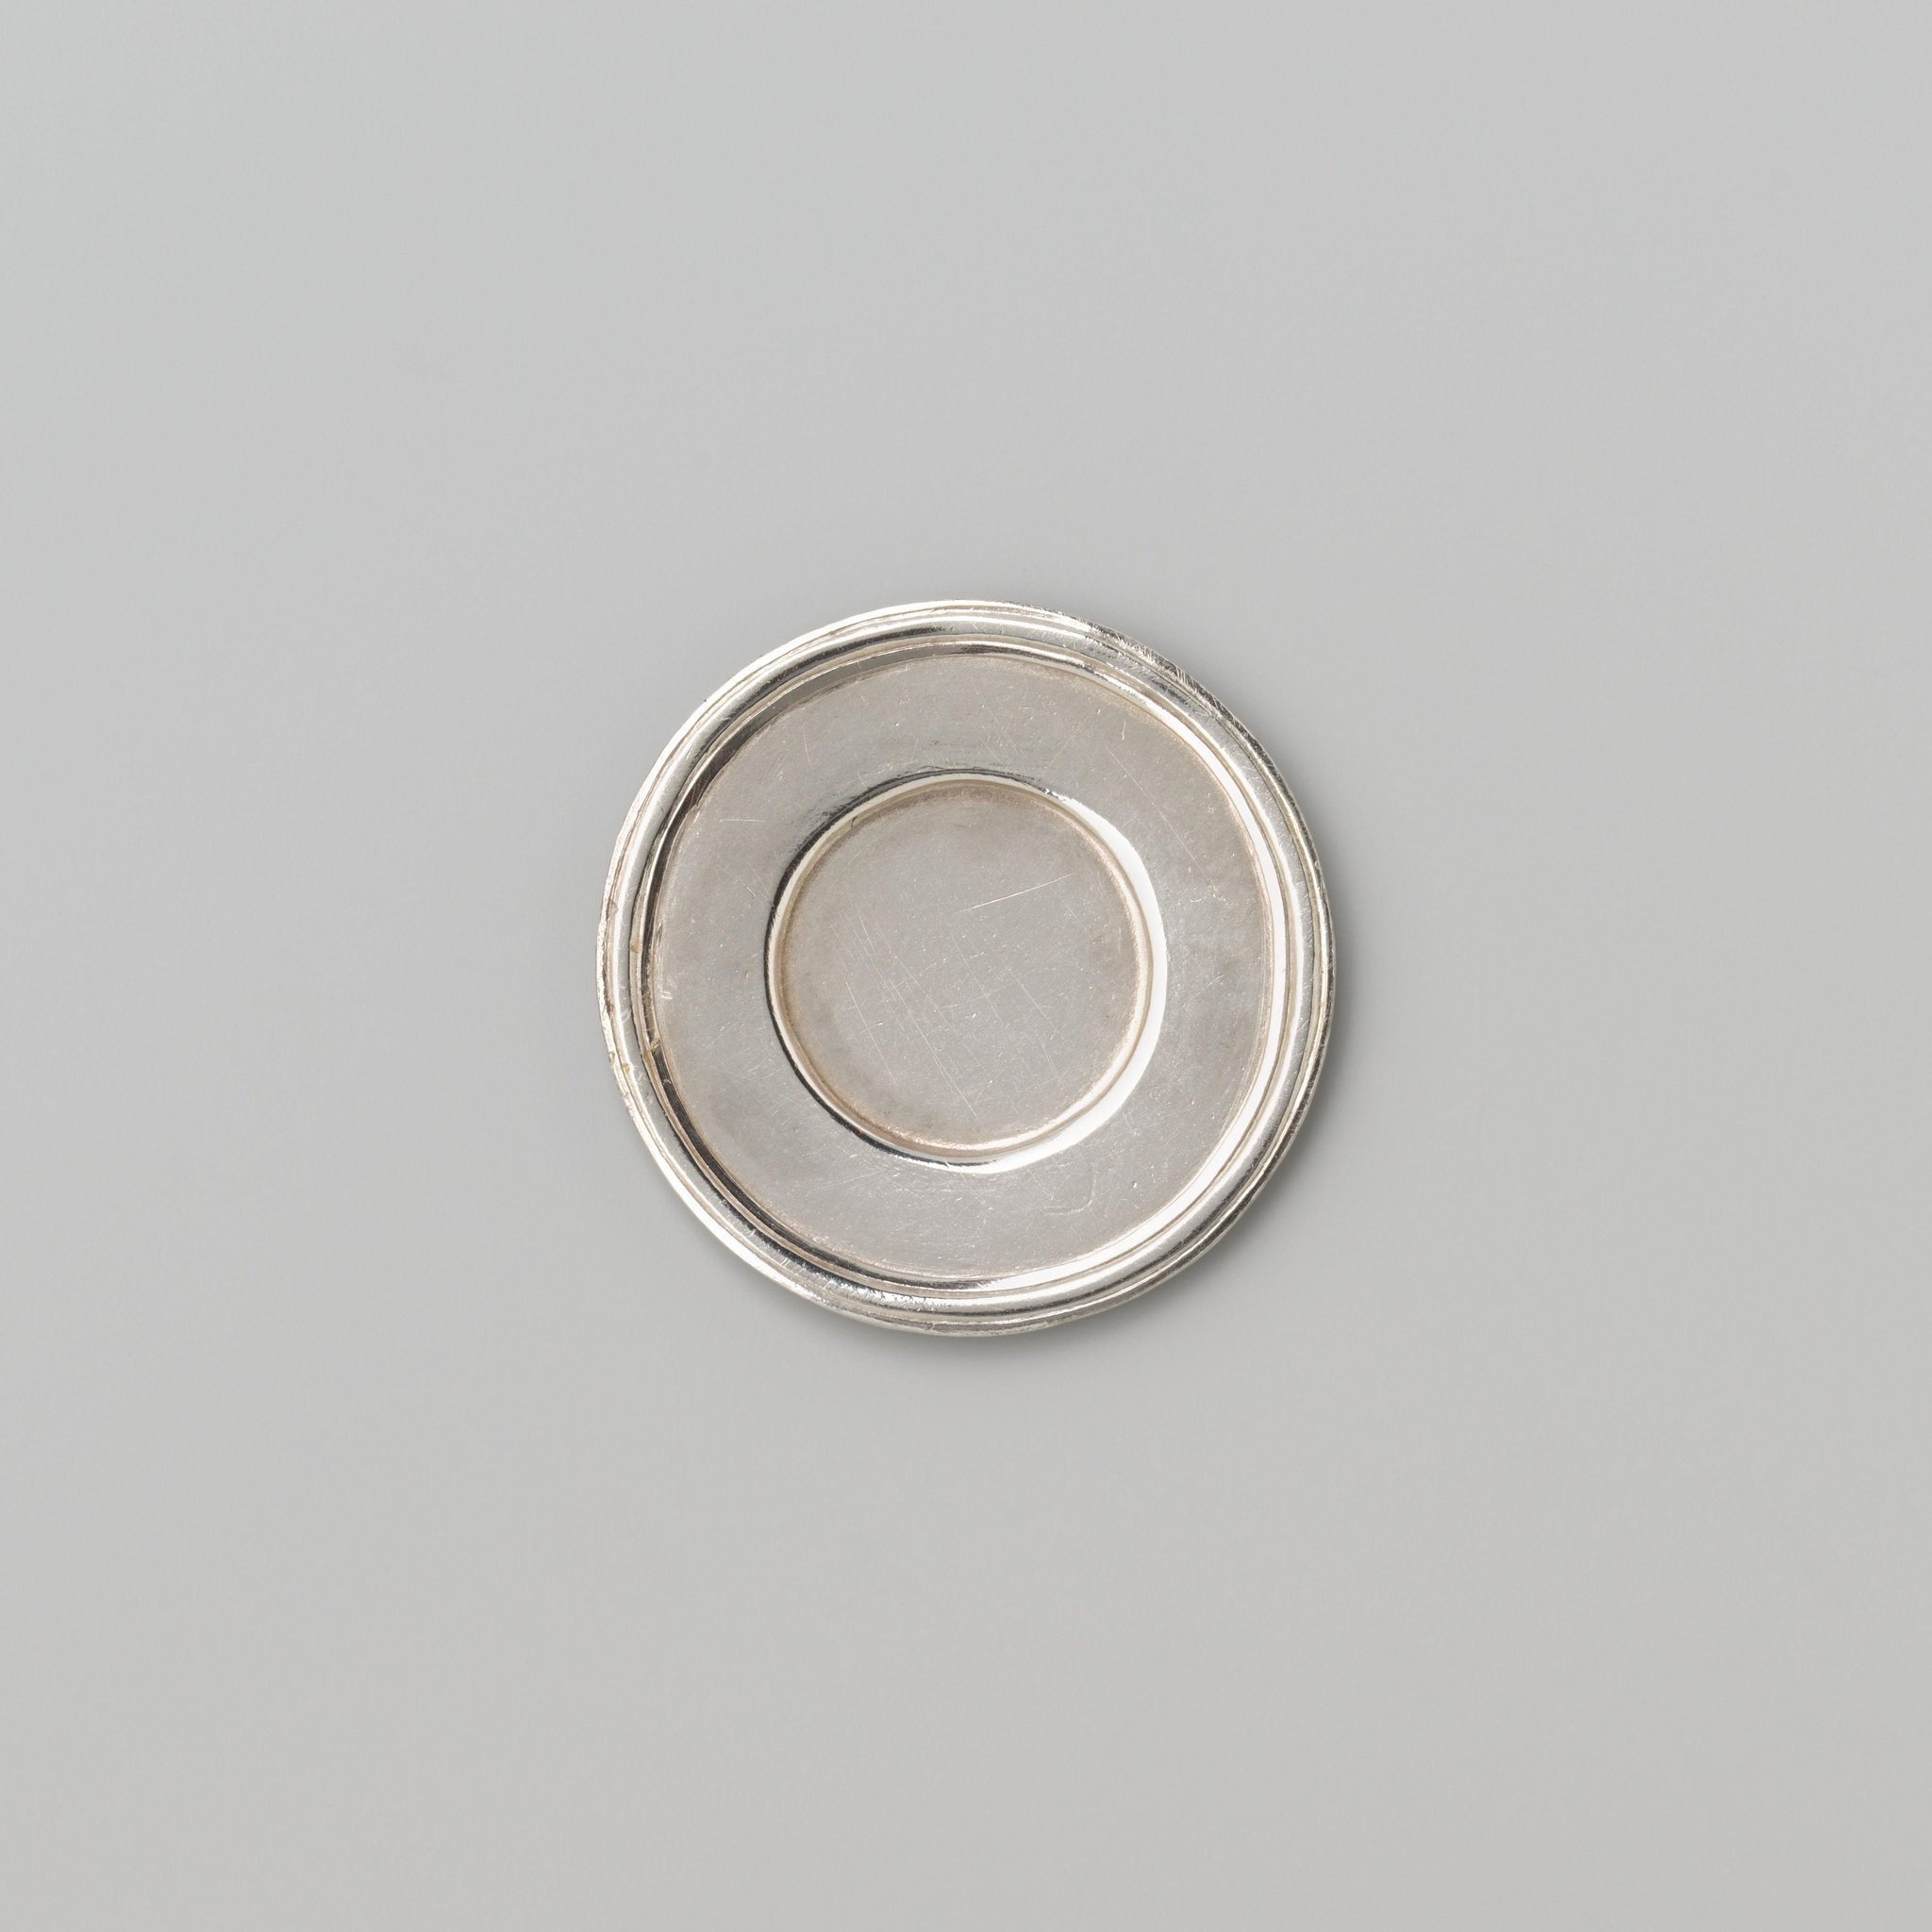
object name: miniature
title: Zilverkleurige schoteltje met brede platte geprofileerde rand.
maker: Anonymous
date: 1700-1710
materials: copper alloy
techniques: silvering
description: Zilverkleurige schotel met brede. platte geprofileerde rand.